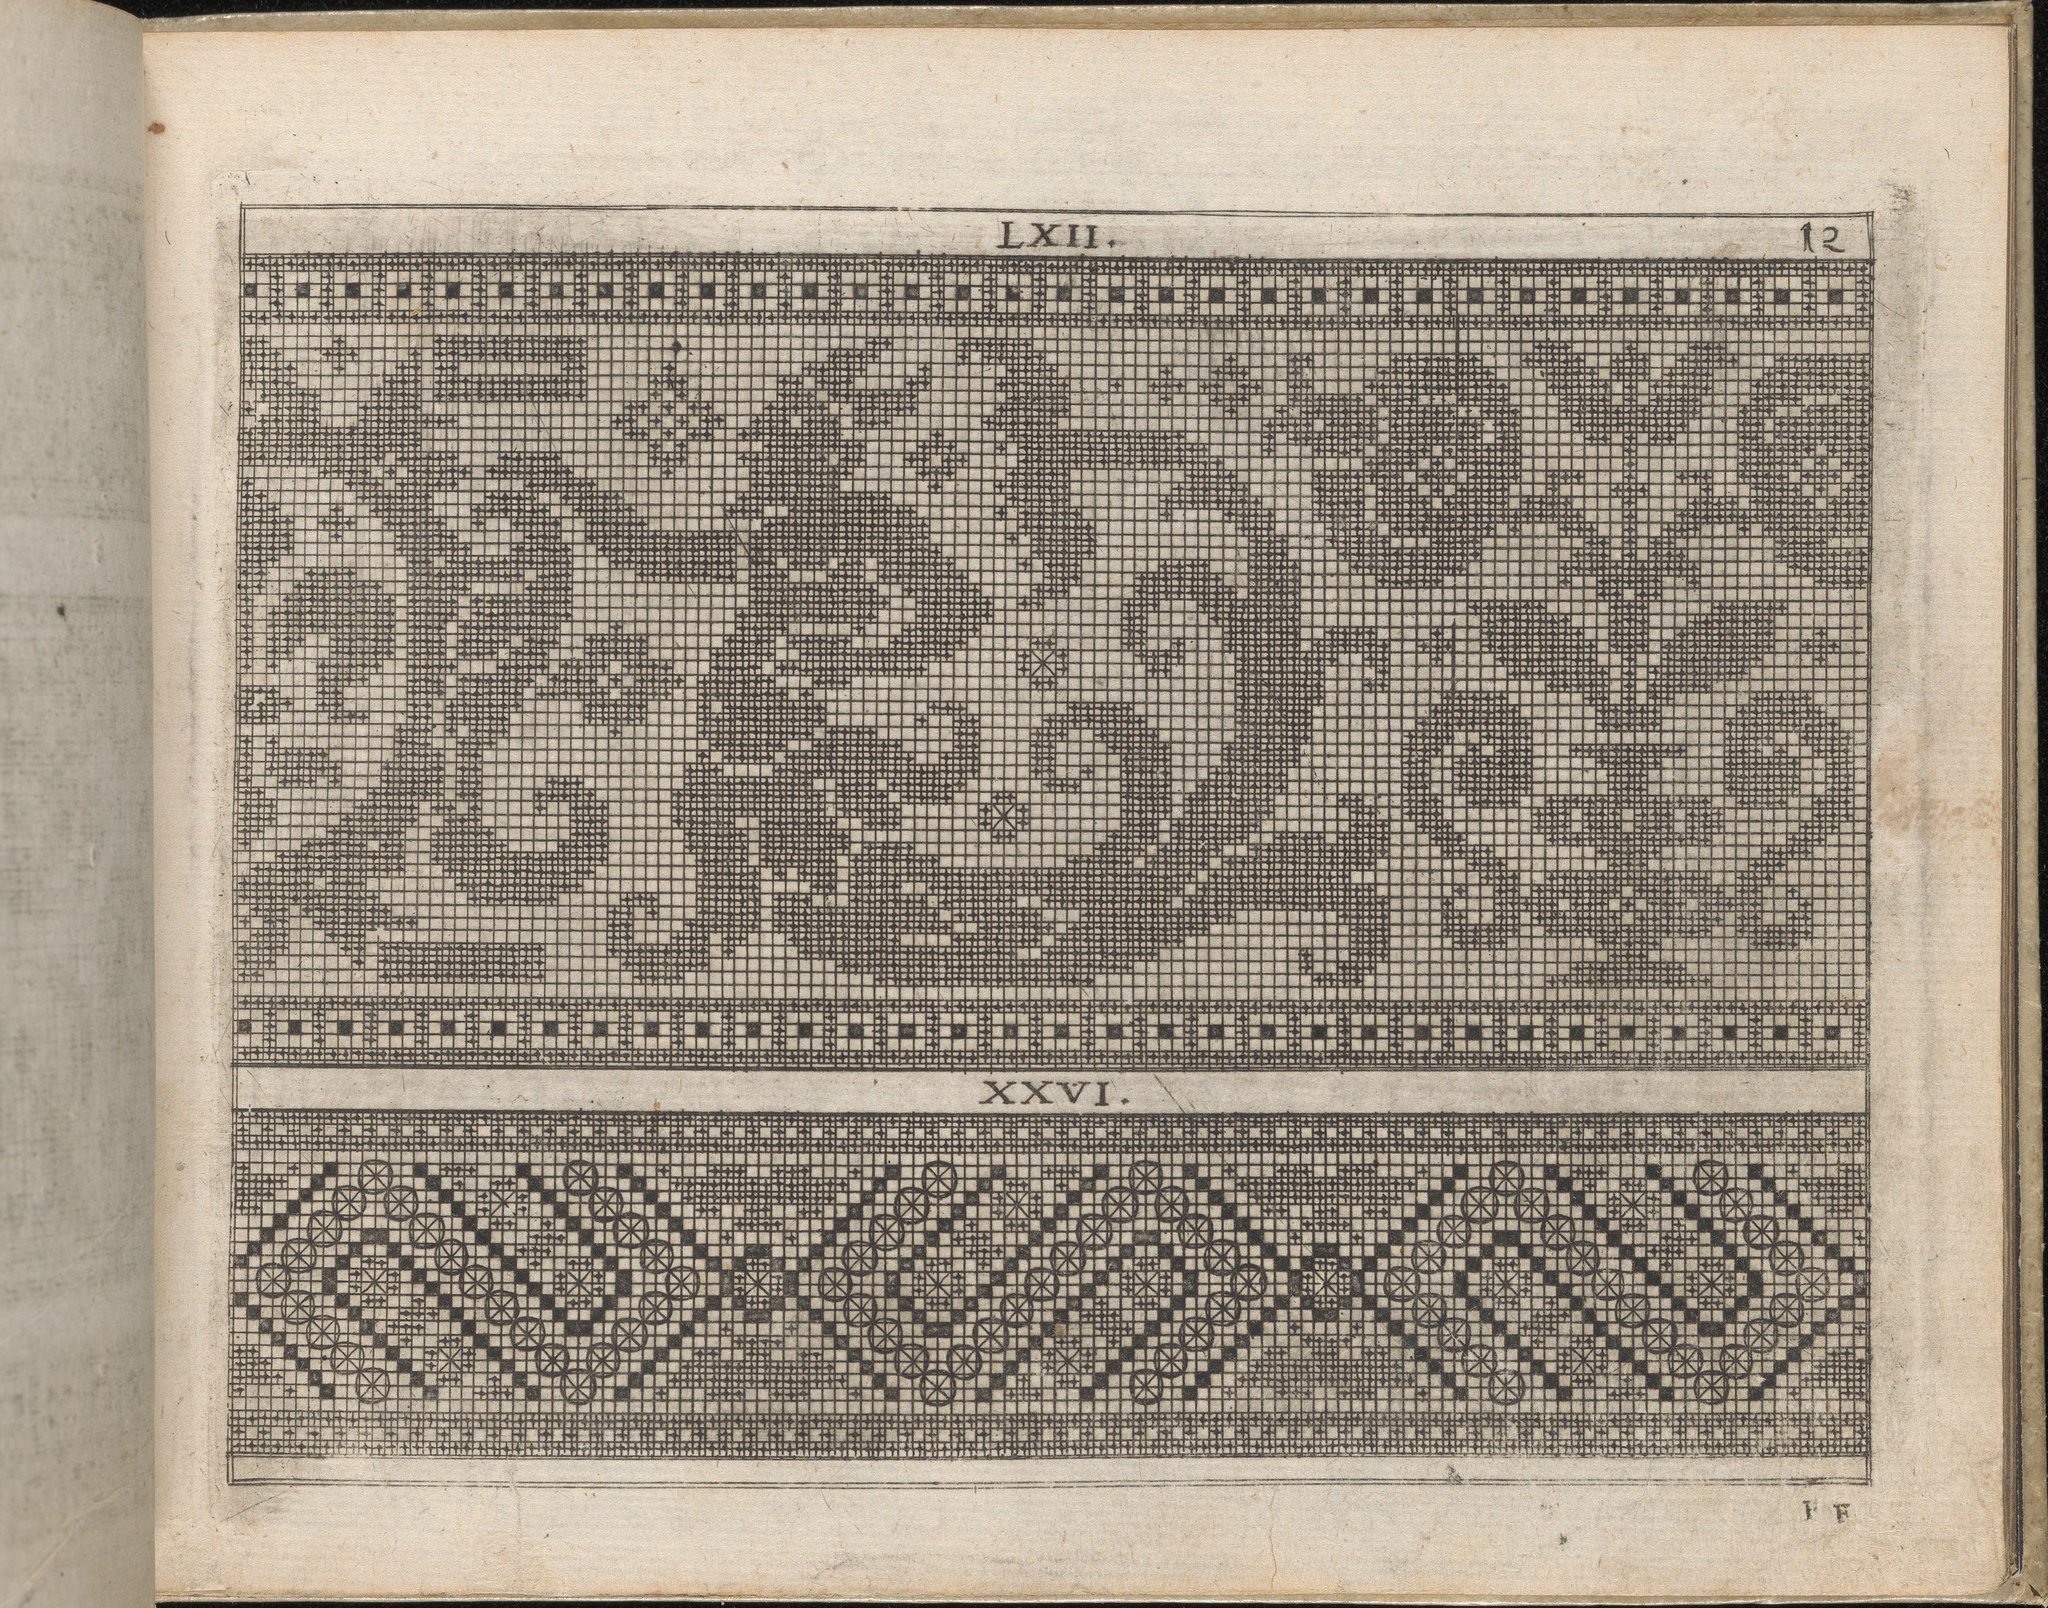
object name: book print ornament architecture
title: Newes Modelbuch in Kupffer (Page 21r)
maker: johann sibmacher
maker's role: artist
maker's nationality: german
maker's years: 1590-1611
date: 1604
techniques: etching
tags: ornament